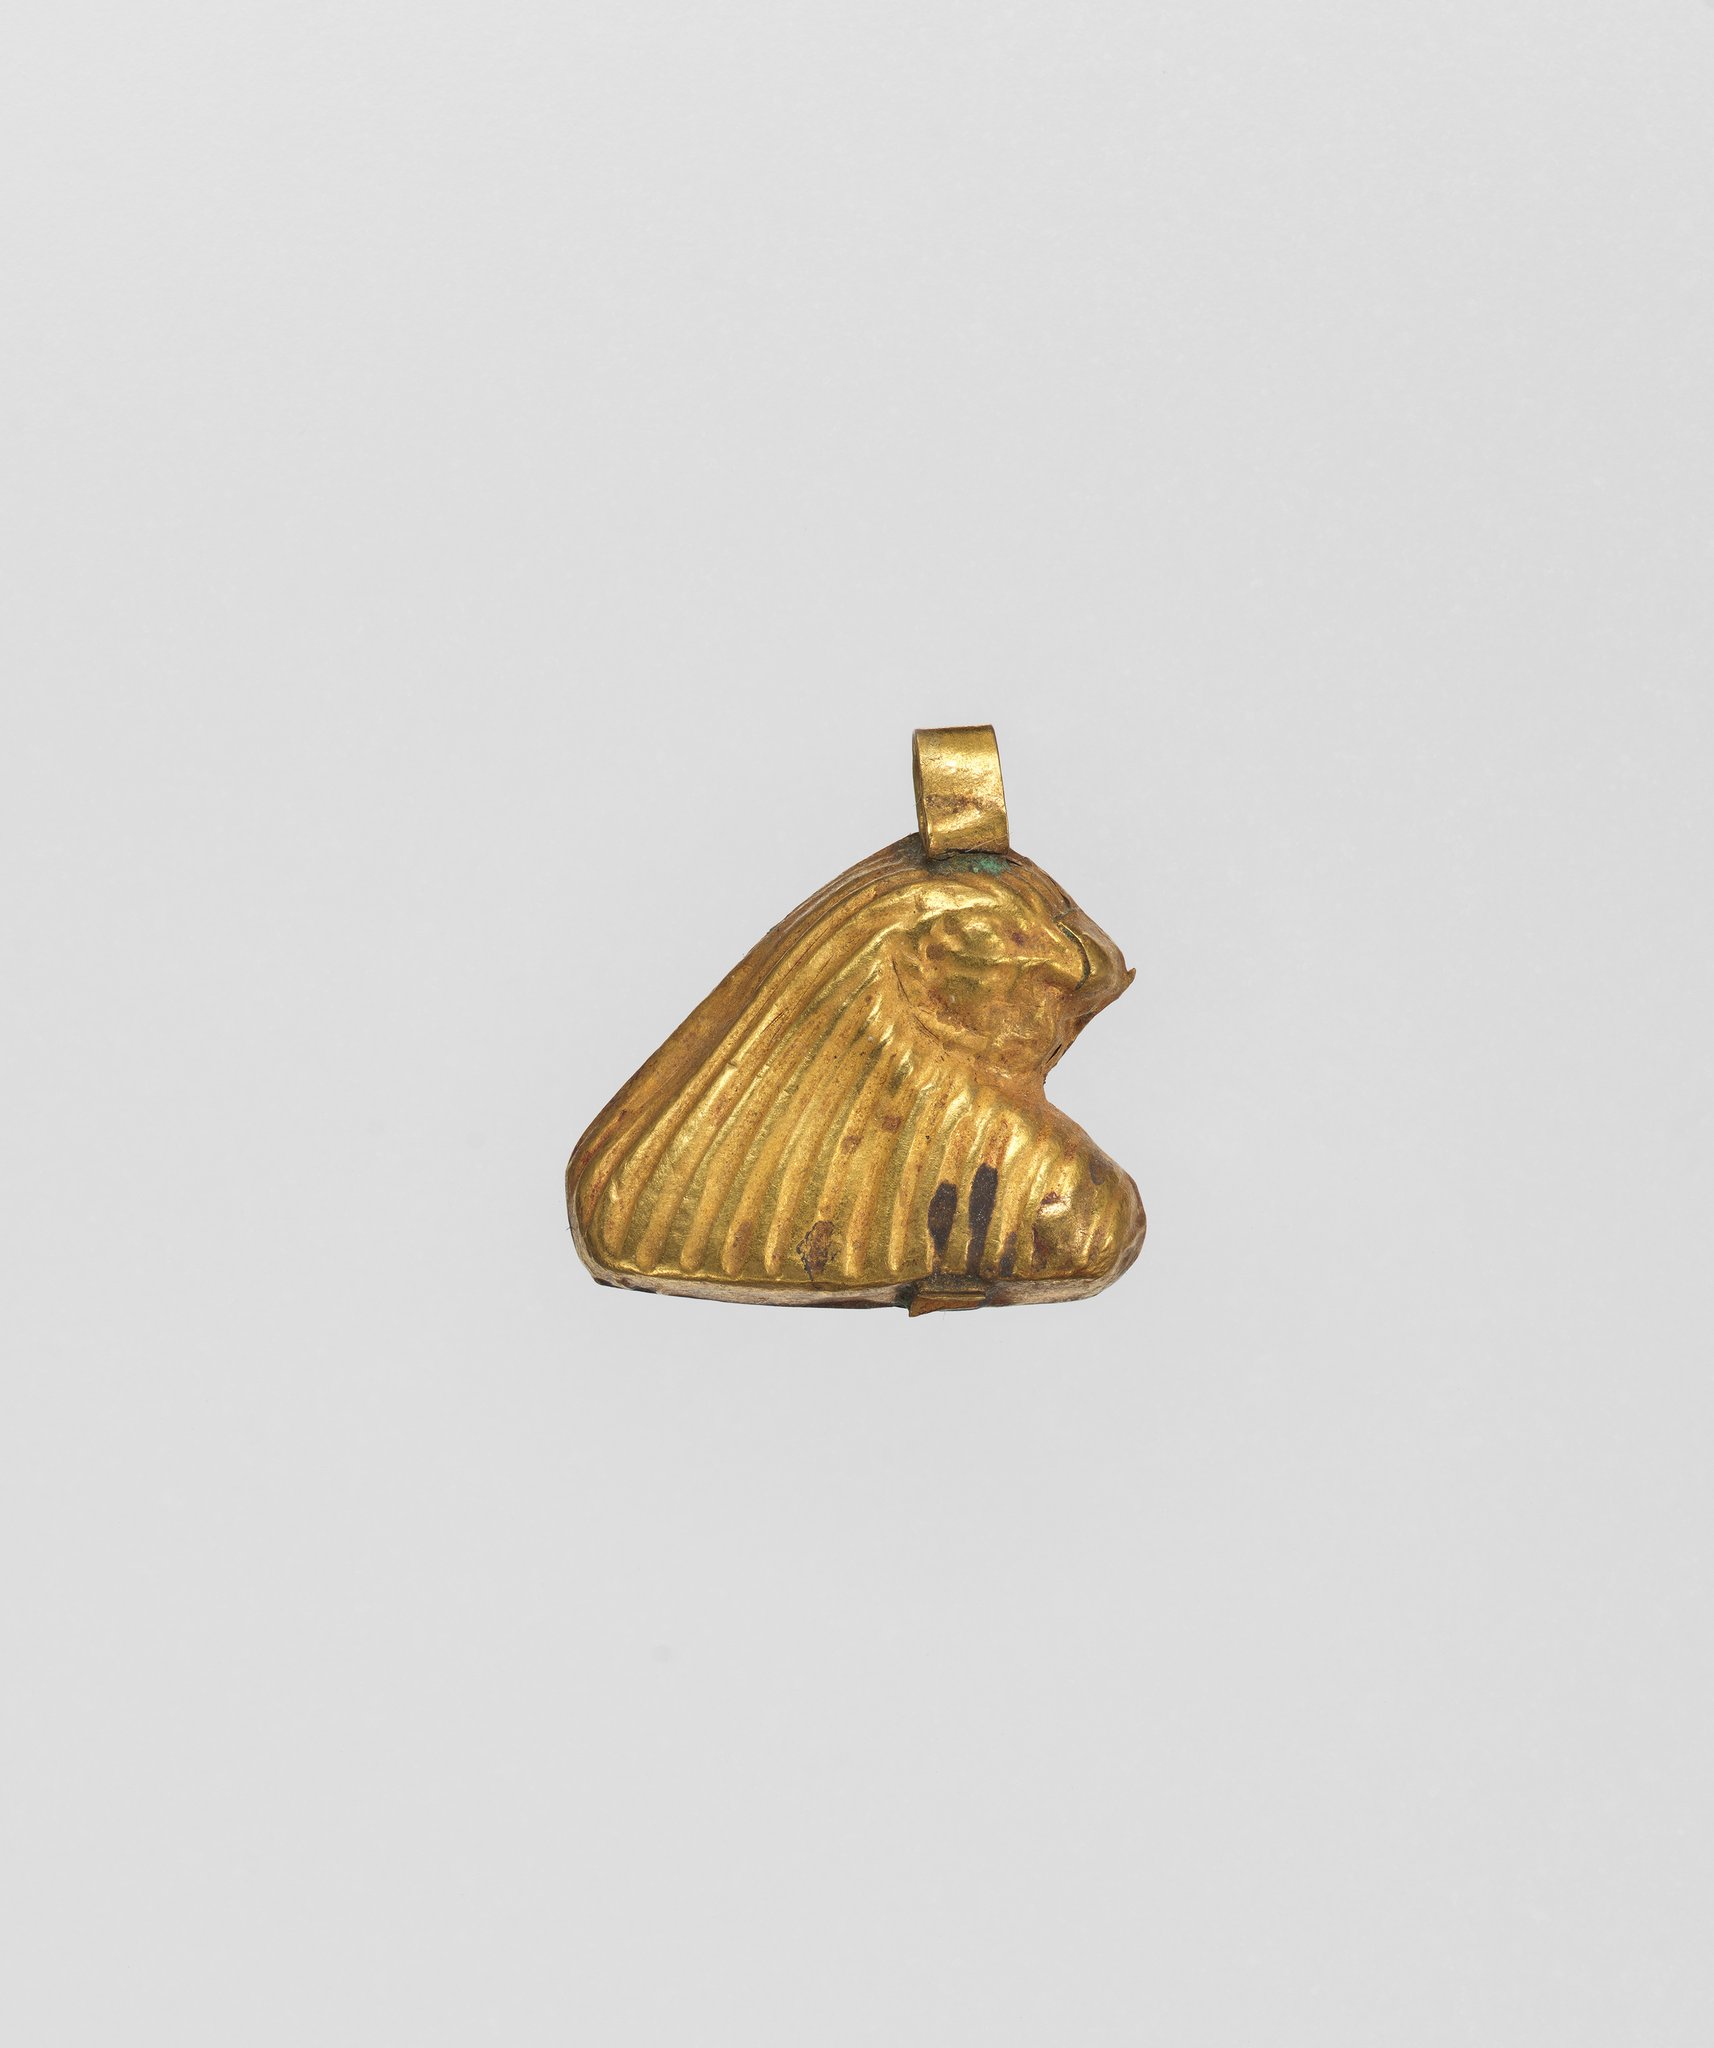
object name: amulet, falcon pendant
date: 332-330 BCE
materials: gold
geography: egypt